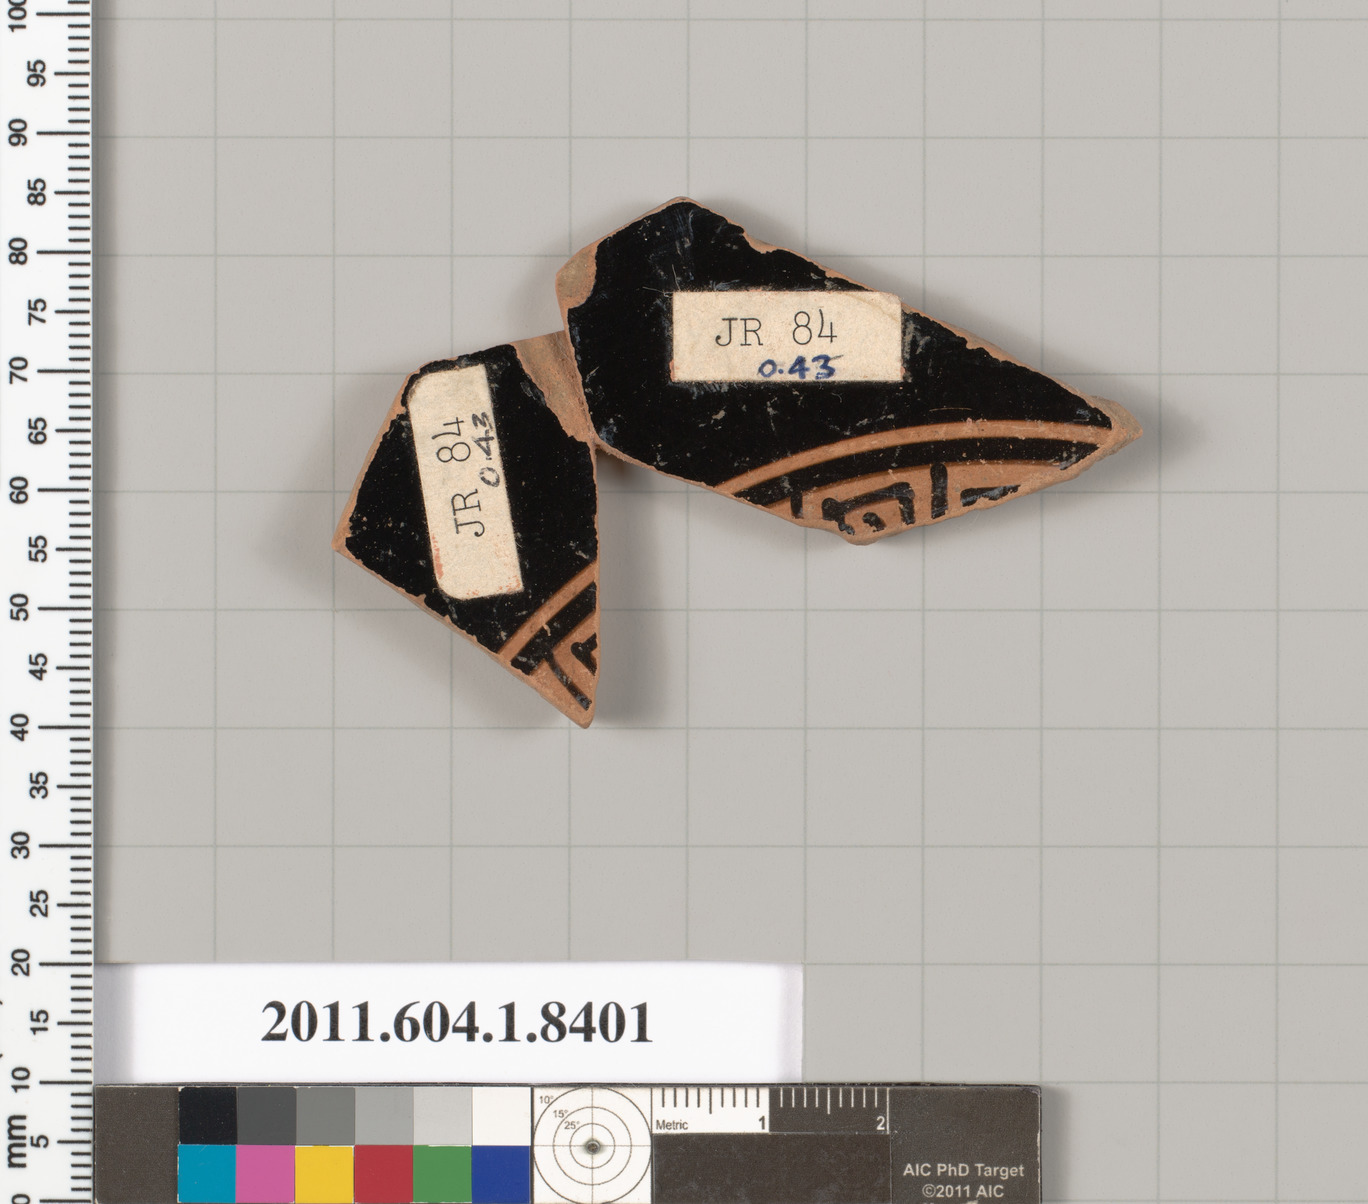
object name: kylix fragment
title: Terracotta fragment of a kylix (drinking cup)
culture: greek, attic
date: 400-351 BCE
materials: terracotta